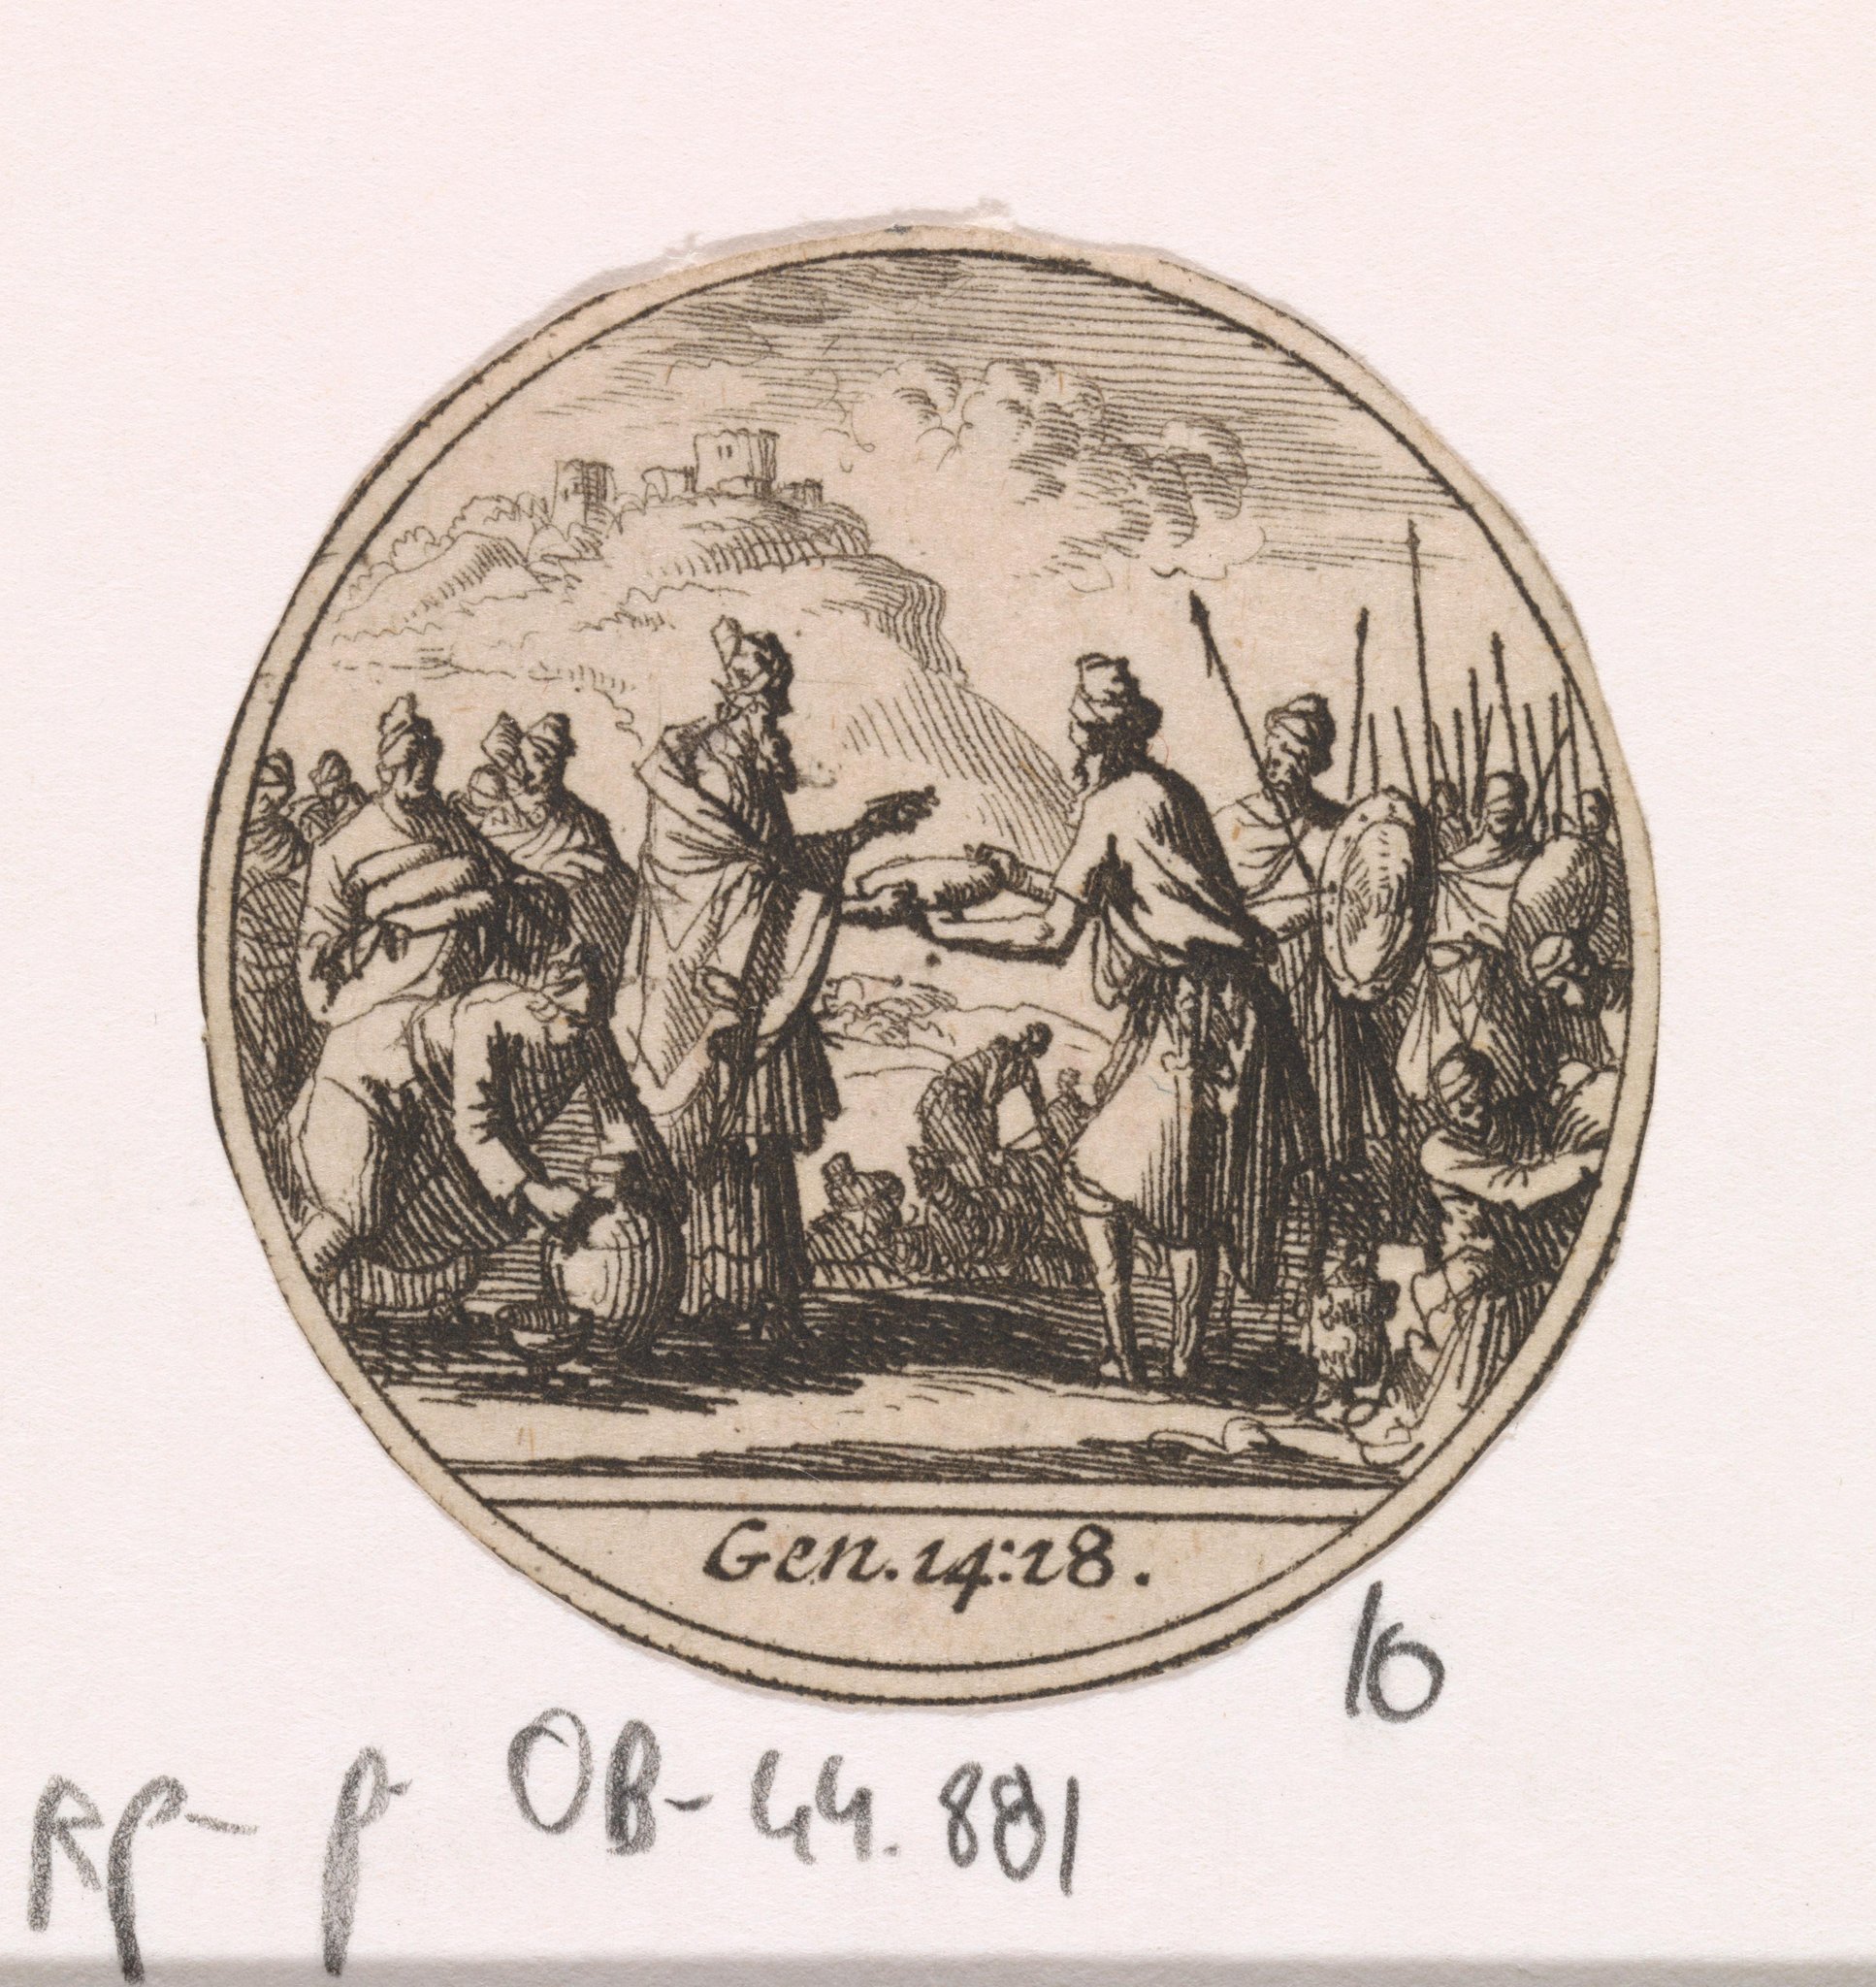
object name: book illustration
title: Abraham ontmoet koning Melchisedek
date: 1700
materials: paper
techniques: etching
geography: amsterdam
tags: the meeting of abraham and melchizedek, the high priest and king of salem, who brings bread and wine (genesis 14:18-20)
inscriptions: collector's mark: Lugt 240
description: Boekillustratie voor Willem Goeree. Mosaize historie der Hebreeuwse kerke. Amsterdam: Willem & David Goeree, 1700.